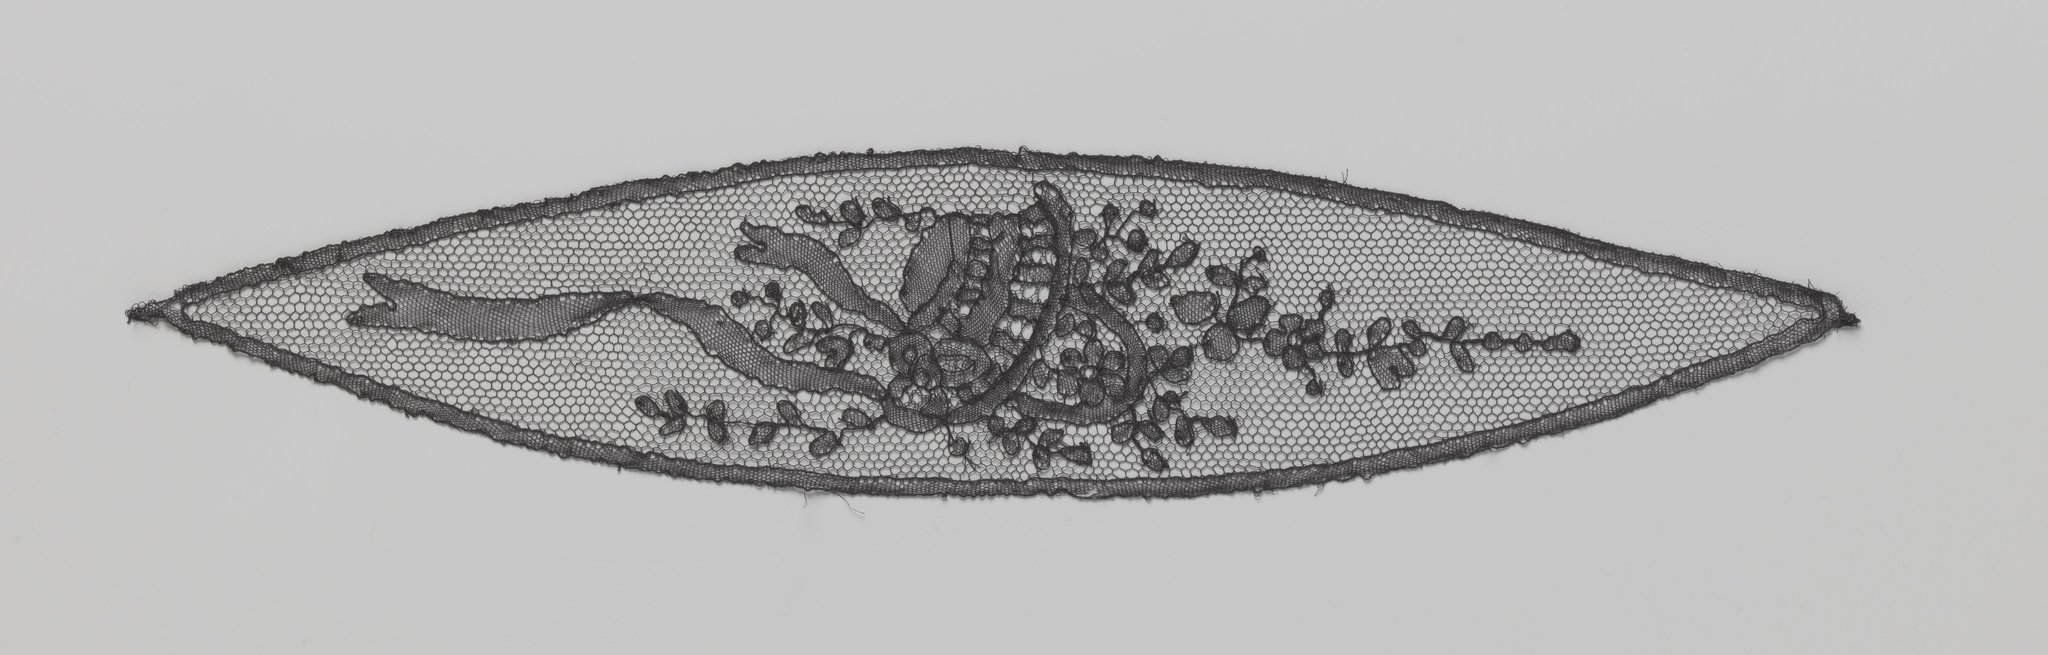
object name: inzetstuk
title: Spitsovaalvormige kousinzet van kloskant met bloemenmand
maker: Anonymous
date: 1911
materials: silk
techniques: lace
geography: geraardsbergen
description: Kousinzet van zwarte kloskant: Chantilly-kant. Spitsovaalvormig model. Het patroon bestaat uit een bloemenmand met linten, die tot in de punt van de kousinzet hangen. De motieven zijn gemaakt in netslag met dikkere contourdraden. Ze zijn met elkaar verbonden door een zeshoekige traliegrond, een tulegrond. Als siergrond is spaarzaam een rozengrond toegepast. Langs de omtrek van de kousinzet is een randje in netslag gemaakt, die aan binnen en buitenzijde is afgewerkt met een dikkere contourdraad.